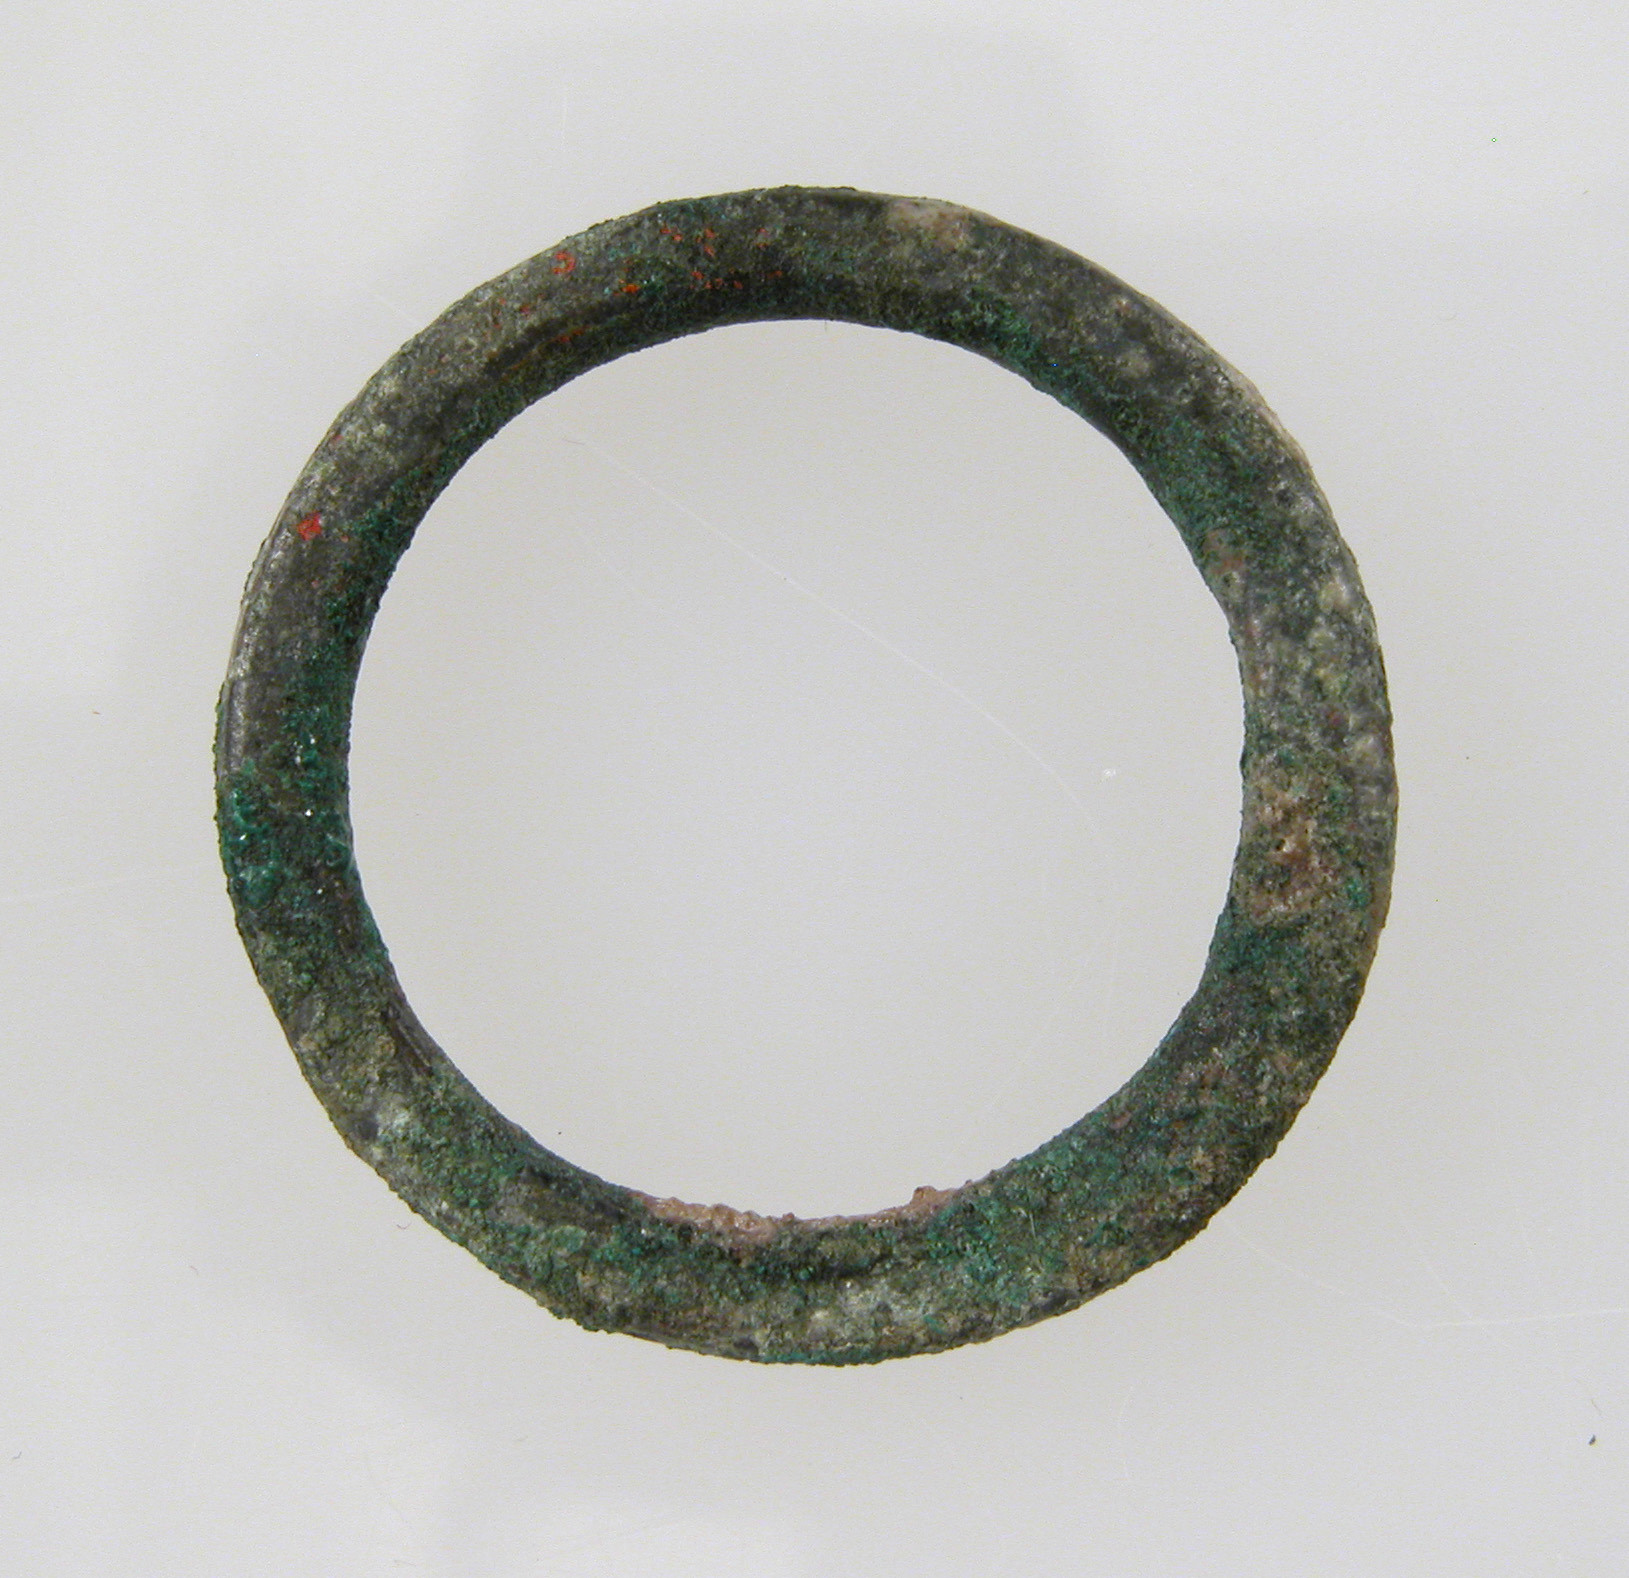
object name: ring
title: Plain Ring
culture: frankish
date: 601-700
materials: copper alloy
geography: northern france